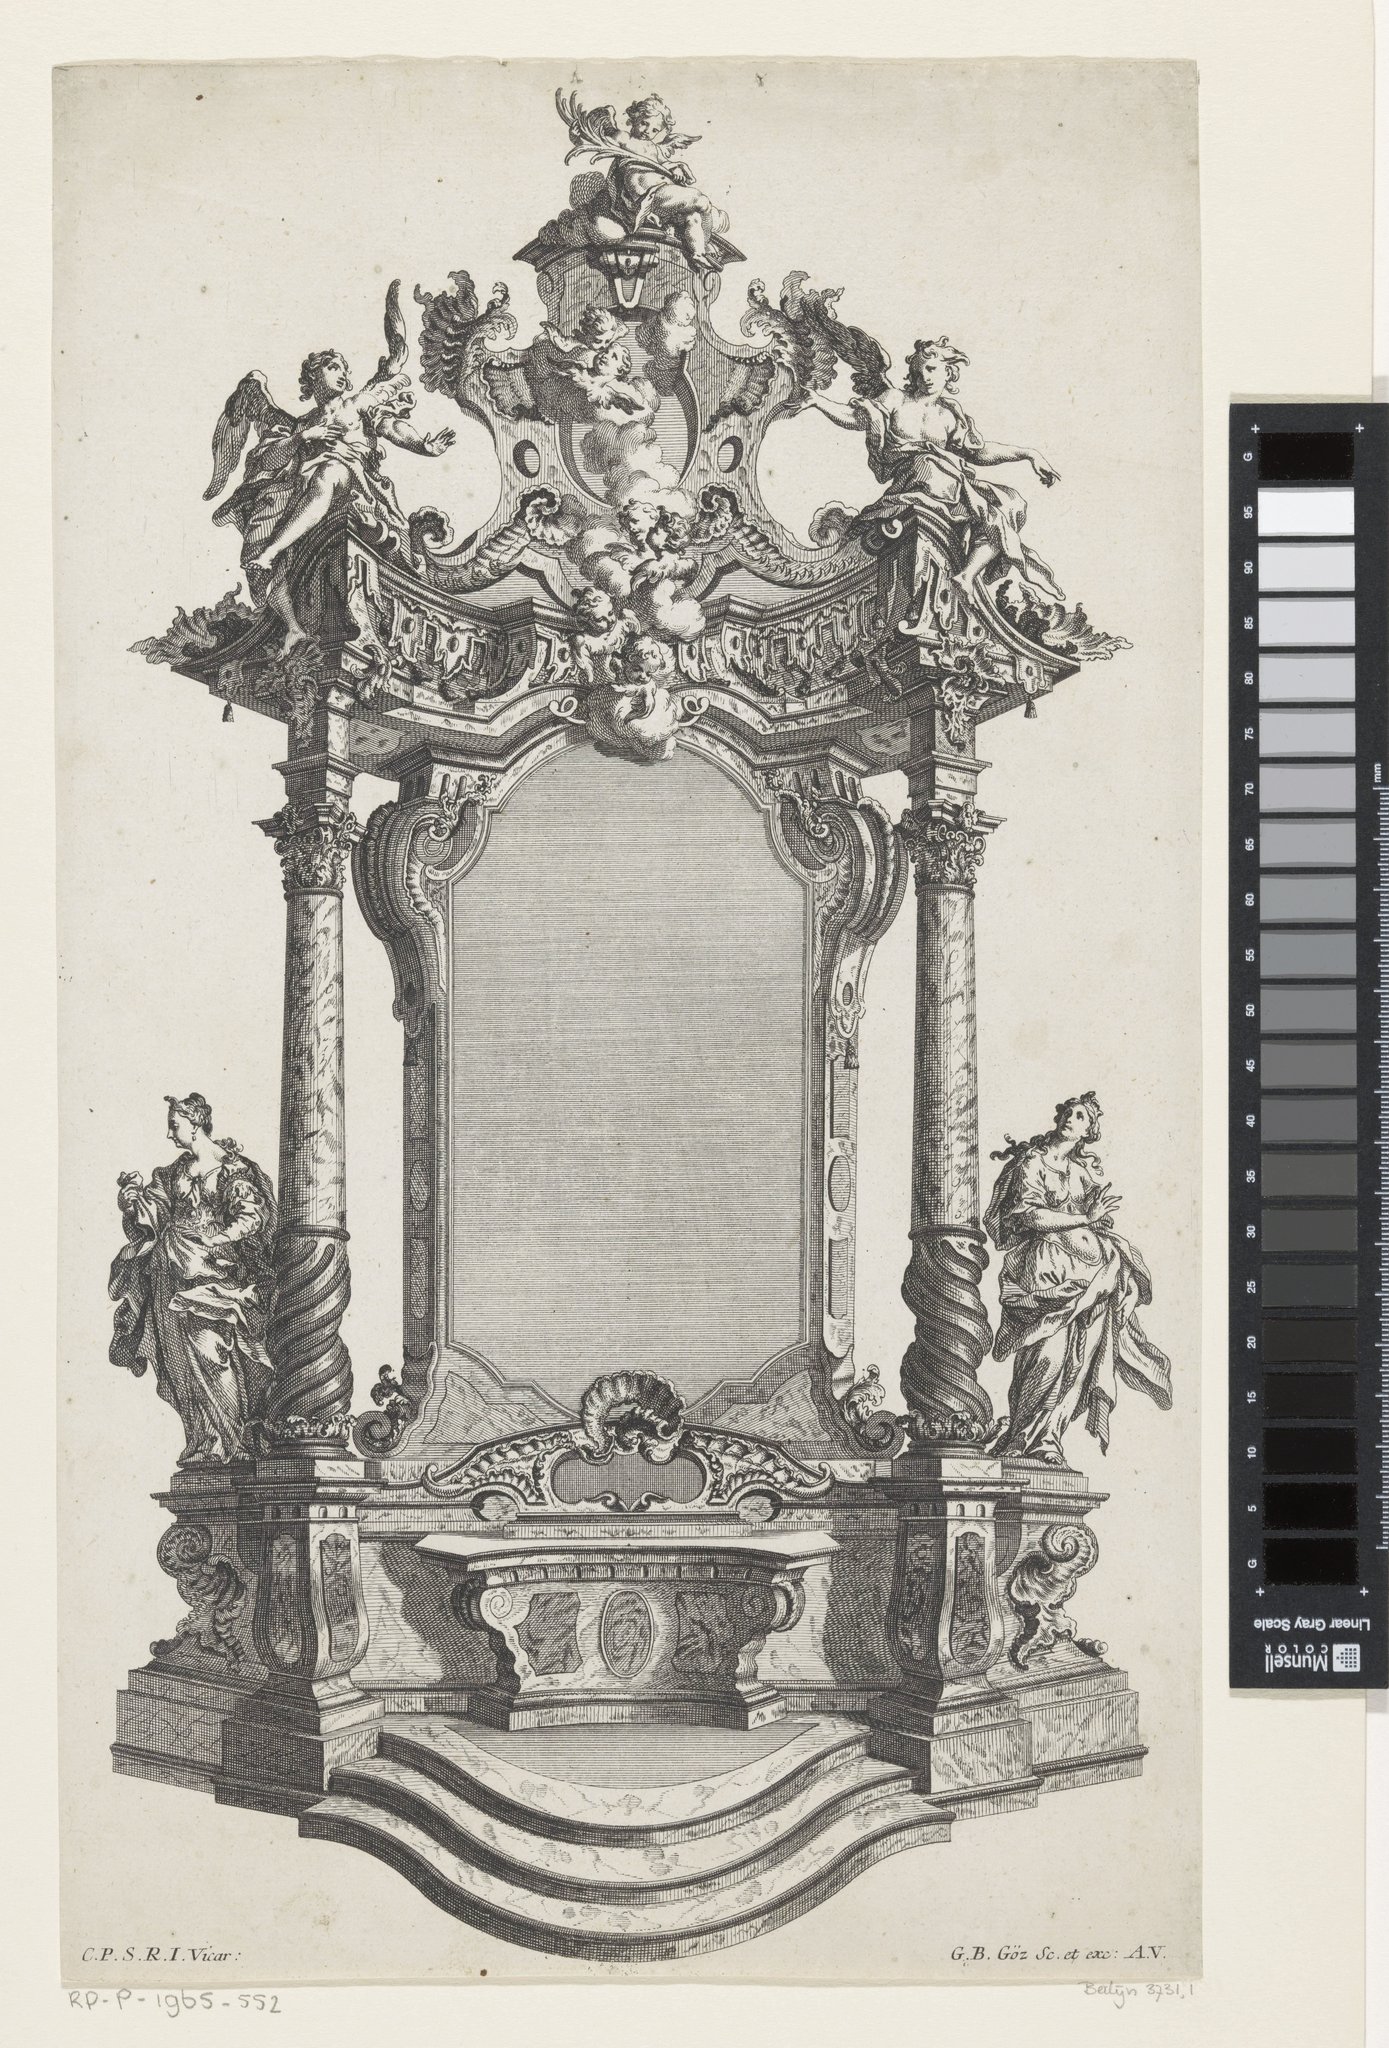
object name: print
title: Altäre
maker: gottfried bernhard götz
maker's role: artist, draughtsman, painter, print maker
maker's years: 1708-1774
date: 1740-1745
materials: paper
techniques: engraving, etching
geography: augsburg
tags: standing figure - aa - female human figure, altar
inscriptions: collector's mark: Lugt 2228, collector's mark: Lugt 2760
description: Een altaar met rocaille ornamenten, met links en rechts een staande vrouw. Tussen de twee engelen op de pilaren van het altaar cherubijnen tussen de wolken. Het altaar wordt aan de bovenzijde afgesloten door een putto.